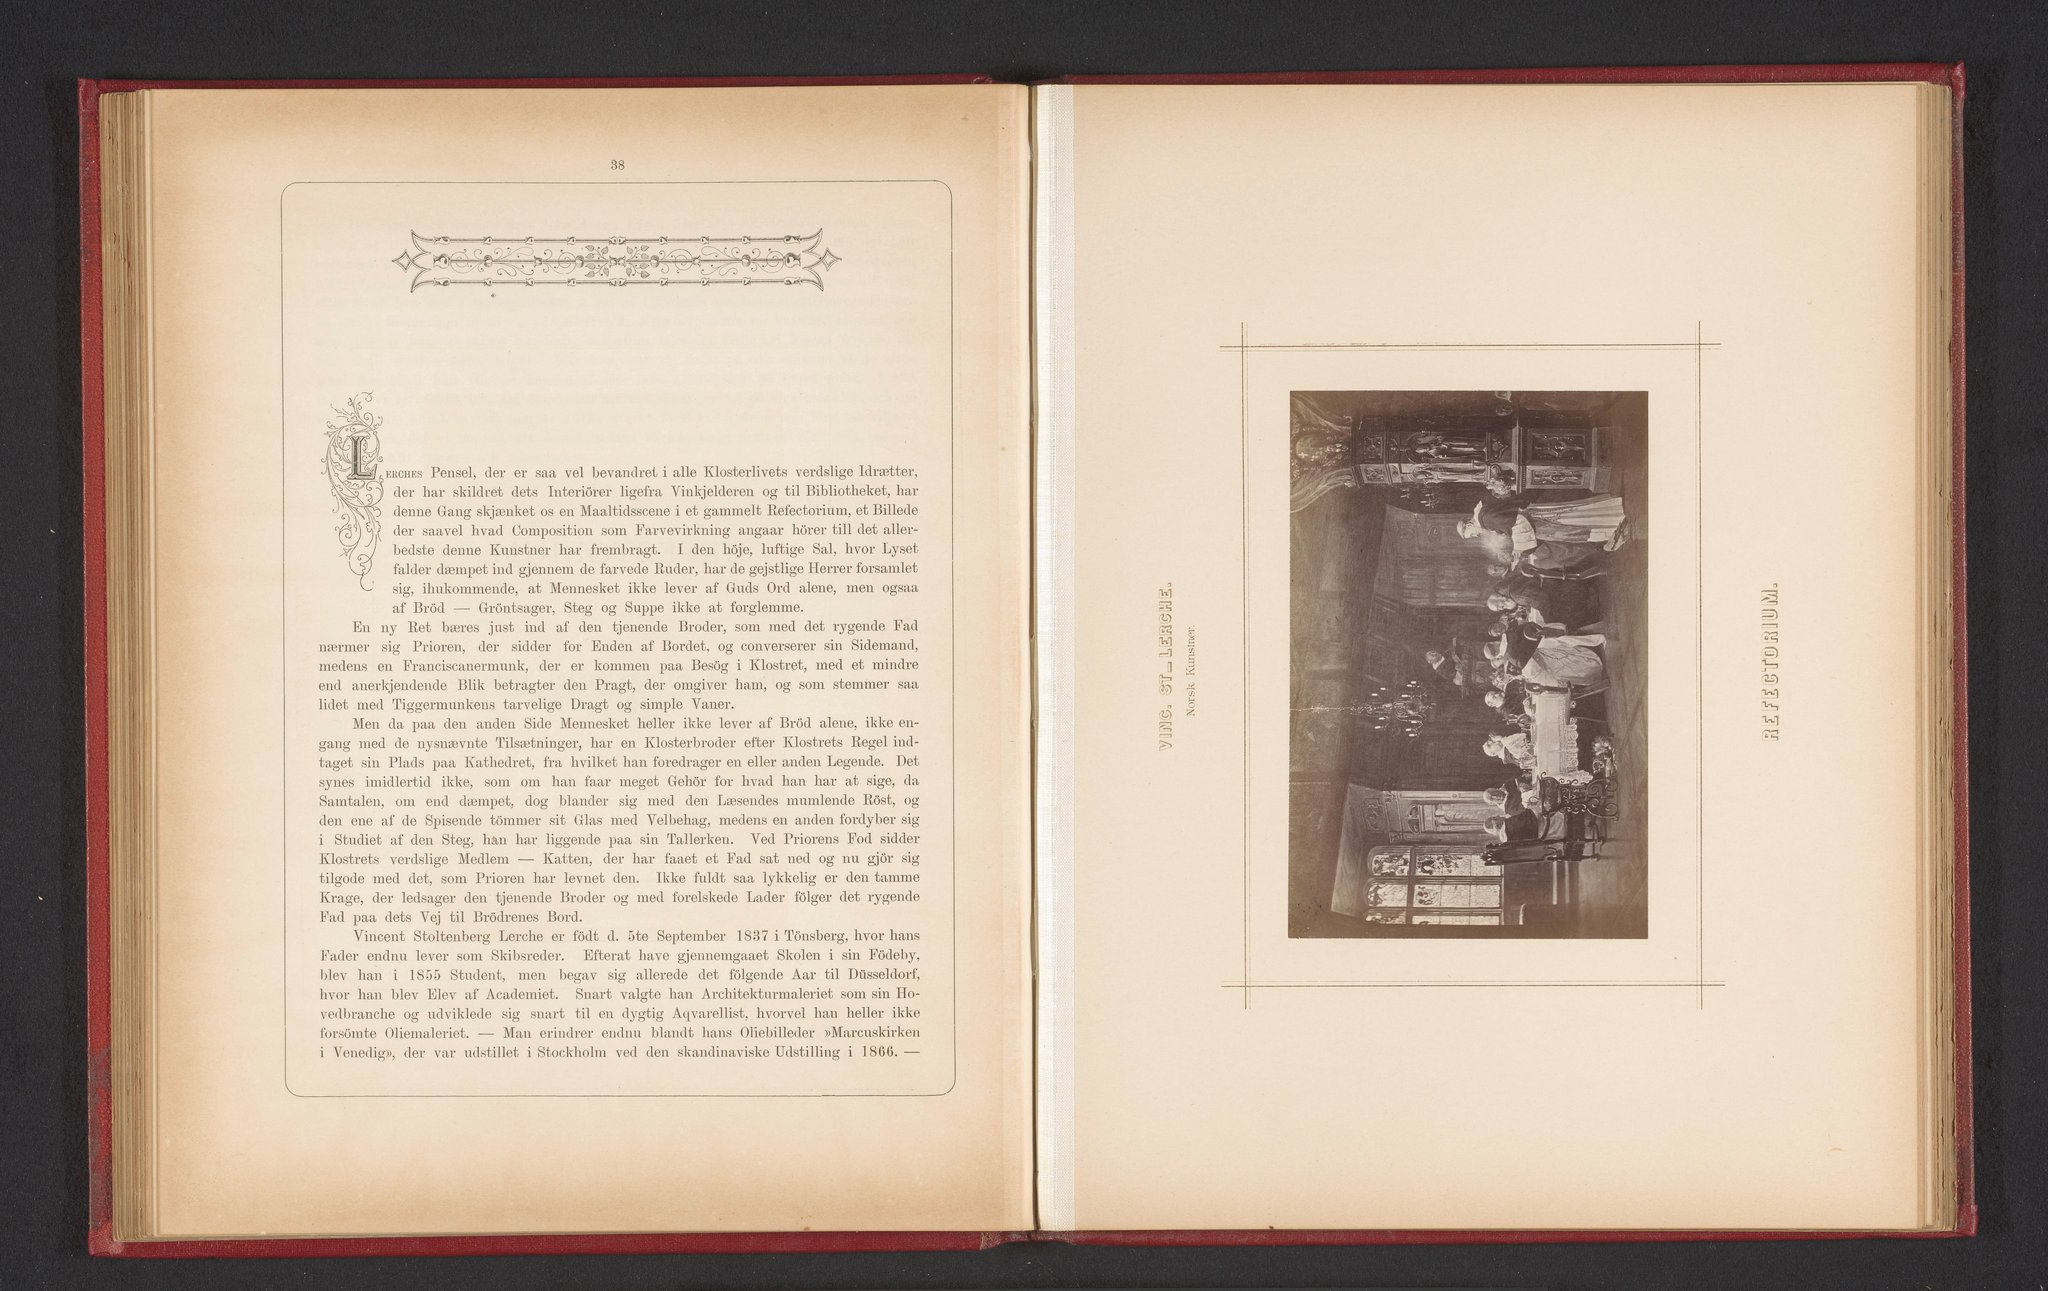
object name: photograph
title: Refectorium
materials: photographic support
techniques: albumen print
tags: theologian, refectory ~ monastery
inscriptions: inscription: ‘Norsk Kunstner’